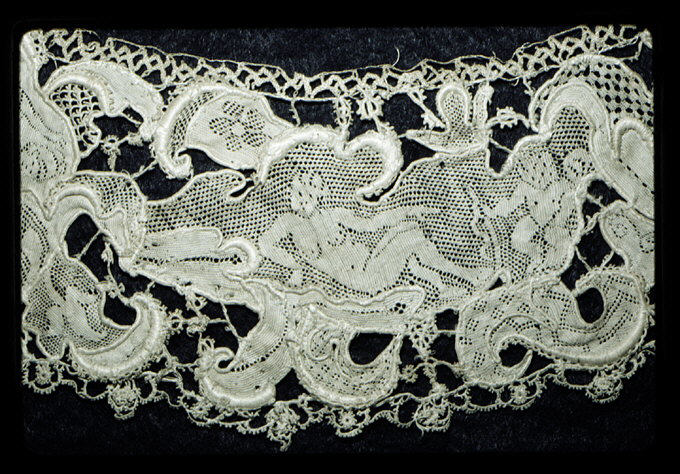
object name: collar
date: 1601-1700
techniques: lace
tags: children,women,flowers